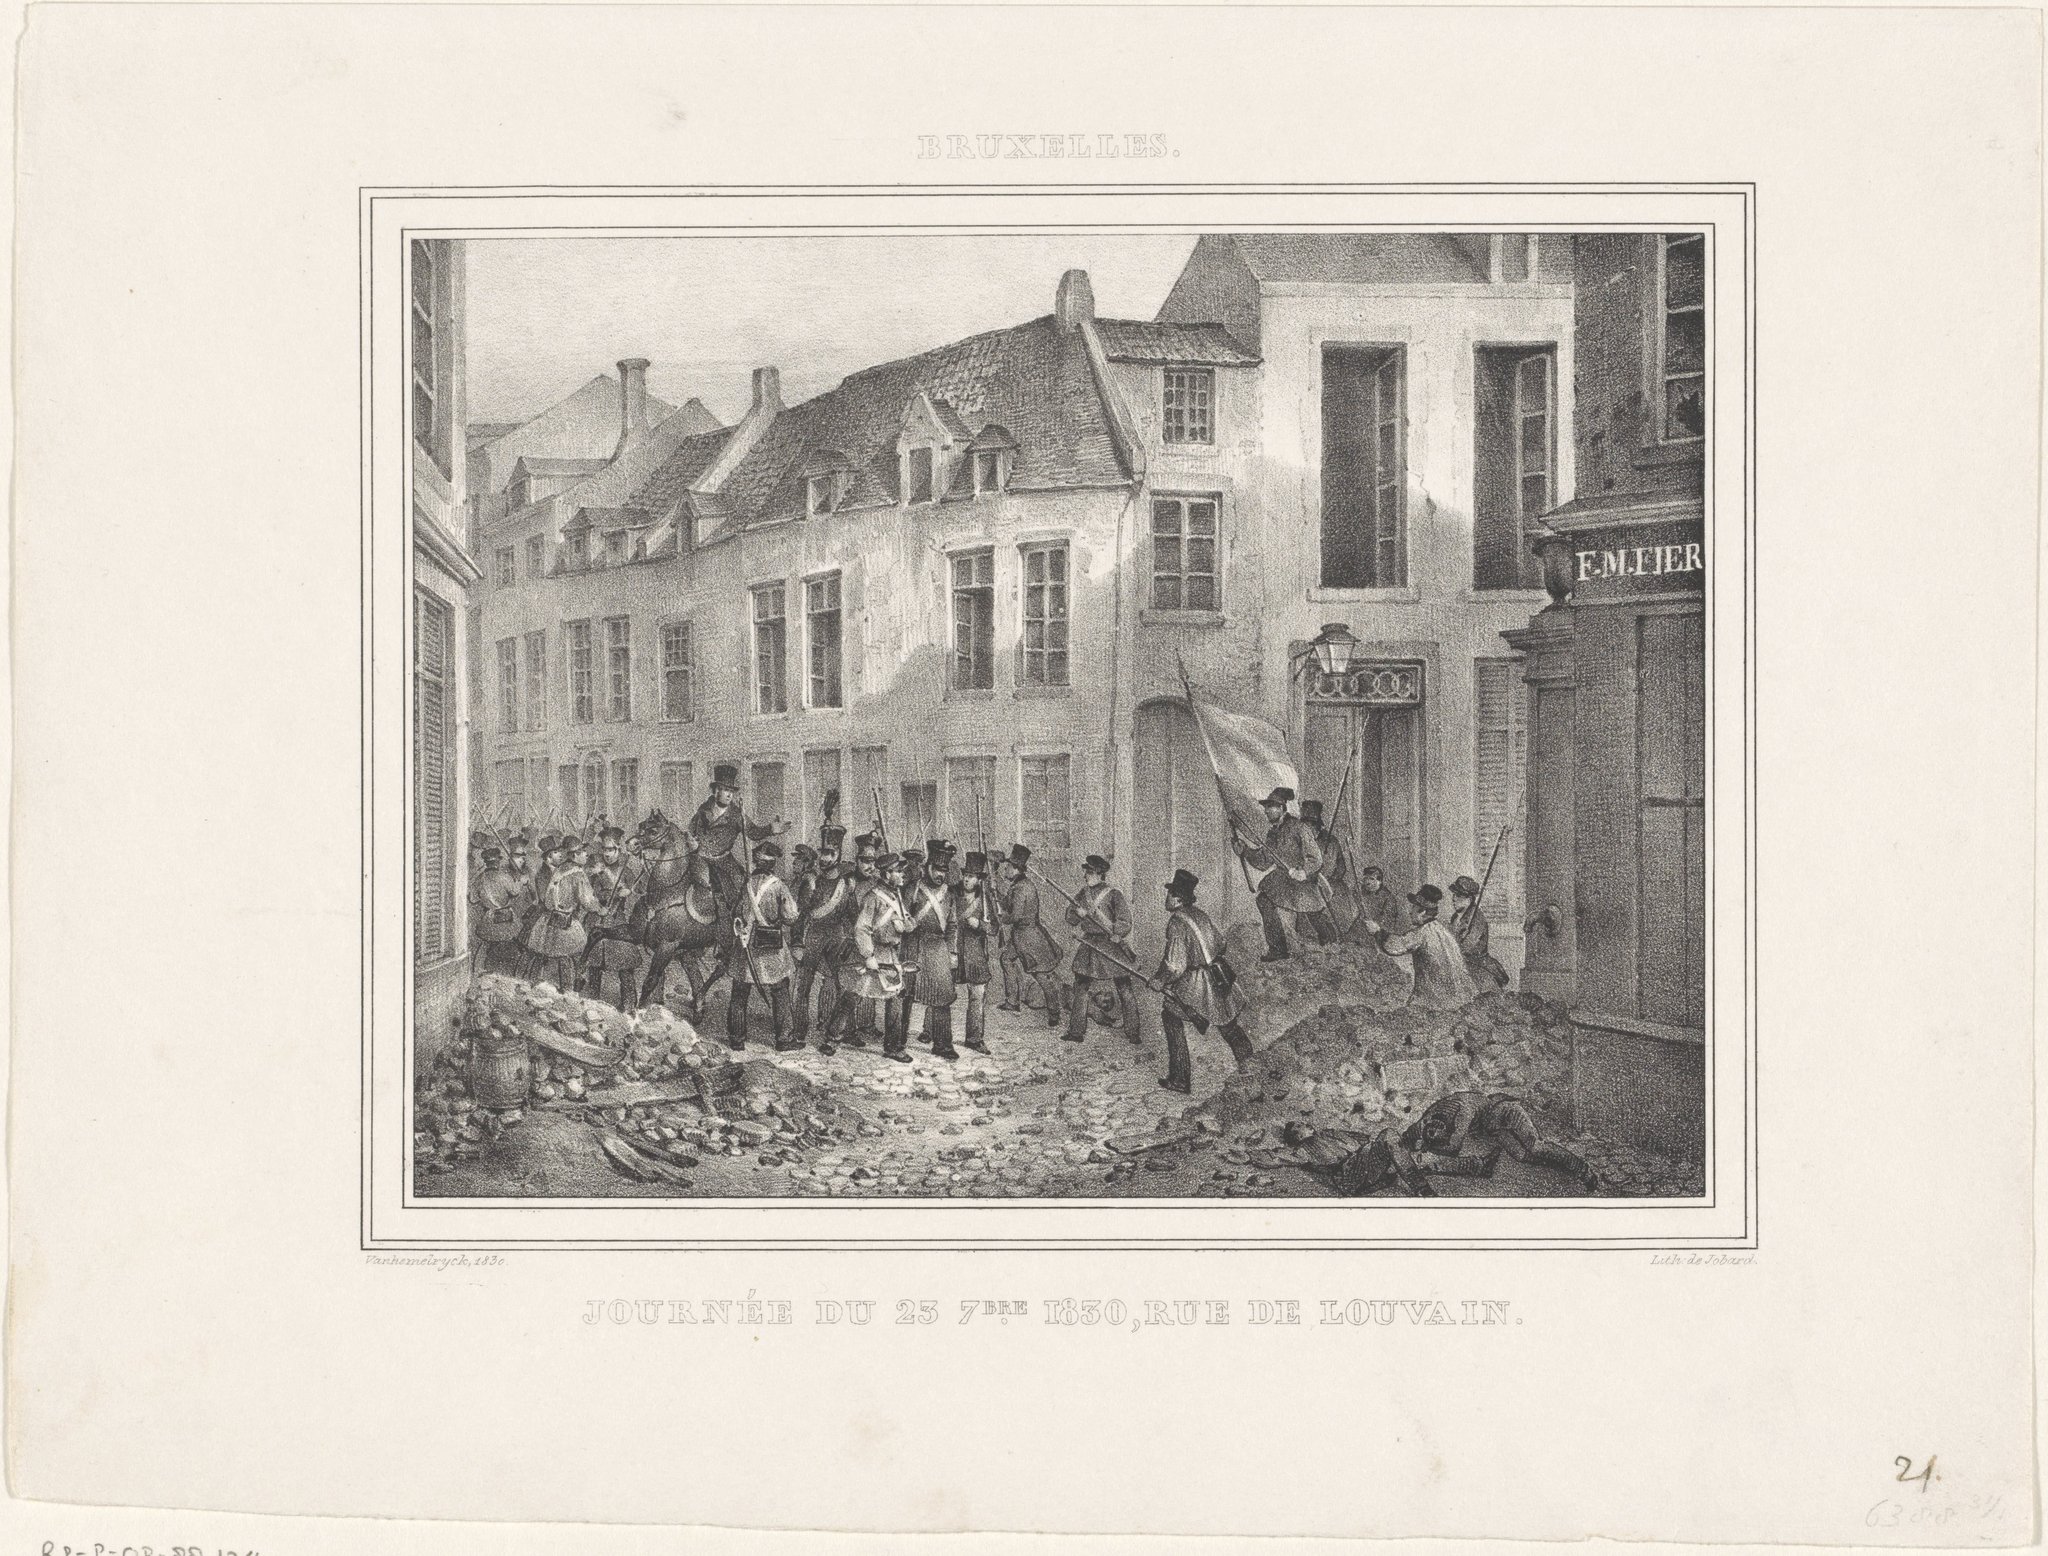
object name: print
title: Prenten toegevoegd aan de serie Evénemens de Bruxelles, Anvers (...) (1831)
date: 1830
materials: paper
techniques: lithograph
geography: brussels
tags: amsterdam, printer, publisher, barricades ~ riot, brussels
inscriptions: collector's mark: Lugt 2228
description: Belgische opstandelingen verzamelen zich in de Leuvenseweg (Rue de Louvain) in Brussel op 23 september 1830. Onderdeel van een groep van prenten uit verschillende andere series verwant aan de platen in het recueil over de gebeurtenissen tijdens de Belgische Revolutie in Brussel, Antwerpen en andere steden in de periode 25 augustus 1830 tot 27 maart 1831.